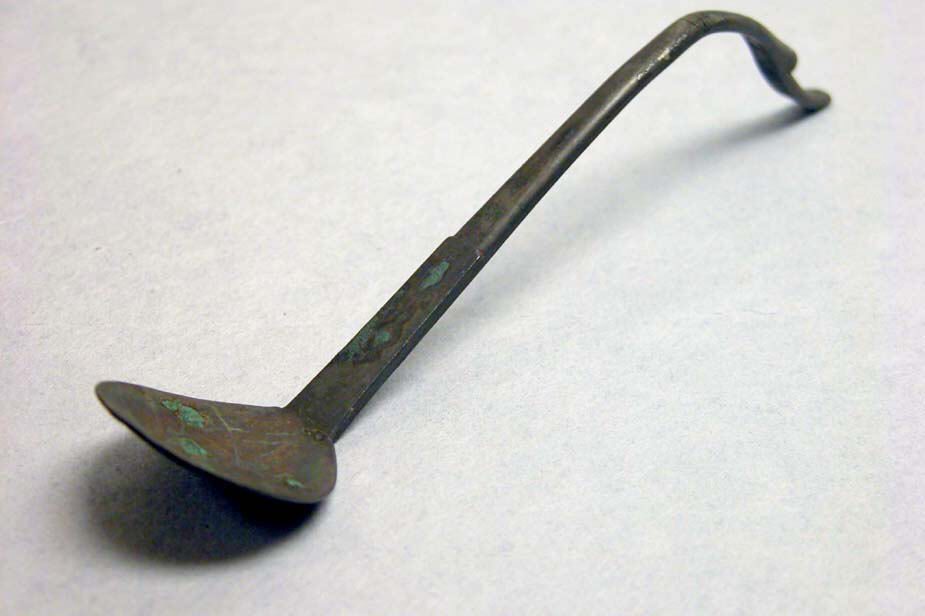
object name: spoon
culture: chinese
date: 618-907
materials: metal, silver